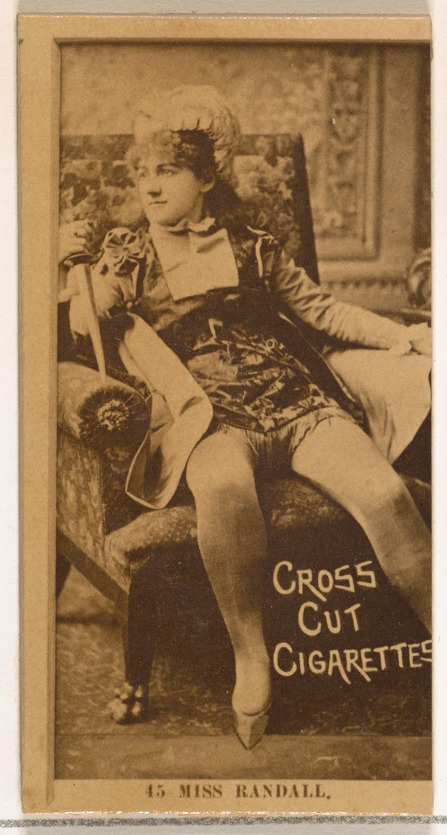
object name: print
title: Card Number 45, Miss Randall, from the Actors and Actresses series (N145-2) issued by Duke Sons & Co. to promote Cross Cut Cigarettes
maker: w. duke, sons & co.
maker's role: publisher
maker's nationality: american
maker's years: 1870-1920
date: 1880-1889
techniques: albumen silver print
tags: portraits,women,actresses